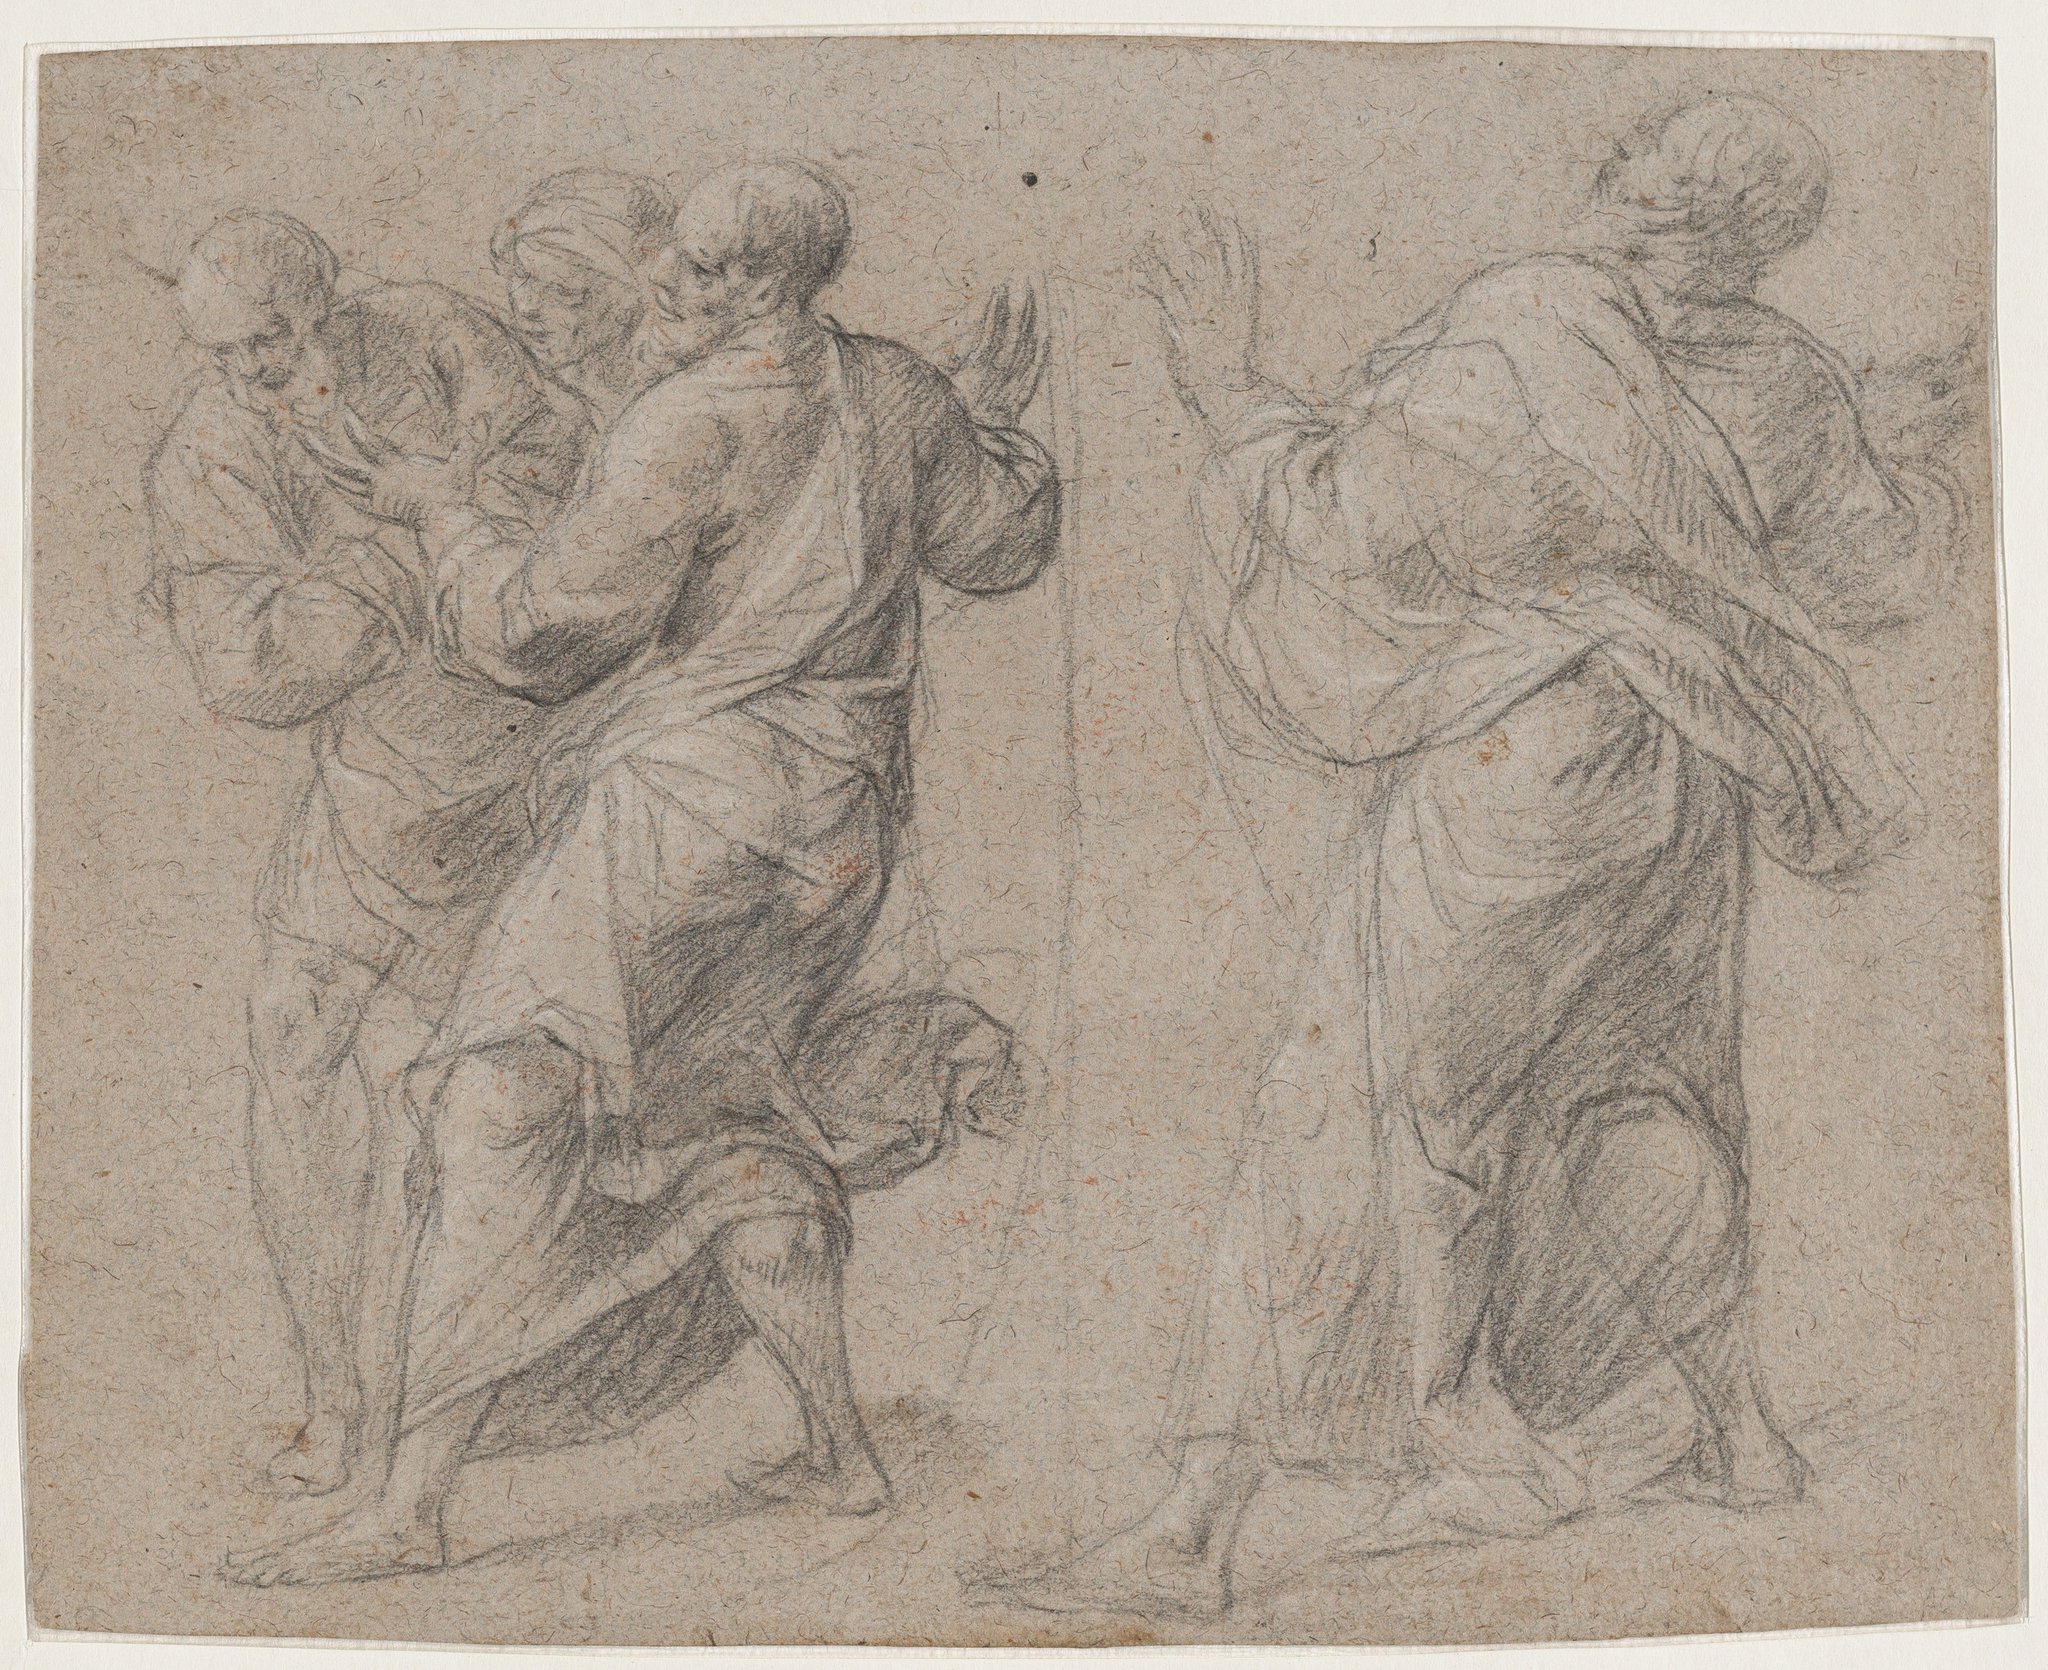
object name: drawing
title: Studies of Figures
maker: antonio busca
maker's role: artist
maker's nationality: italian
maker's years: 1625-1686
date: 1660-1670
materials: chalk, paper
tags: men